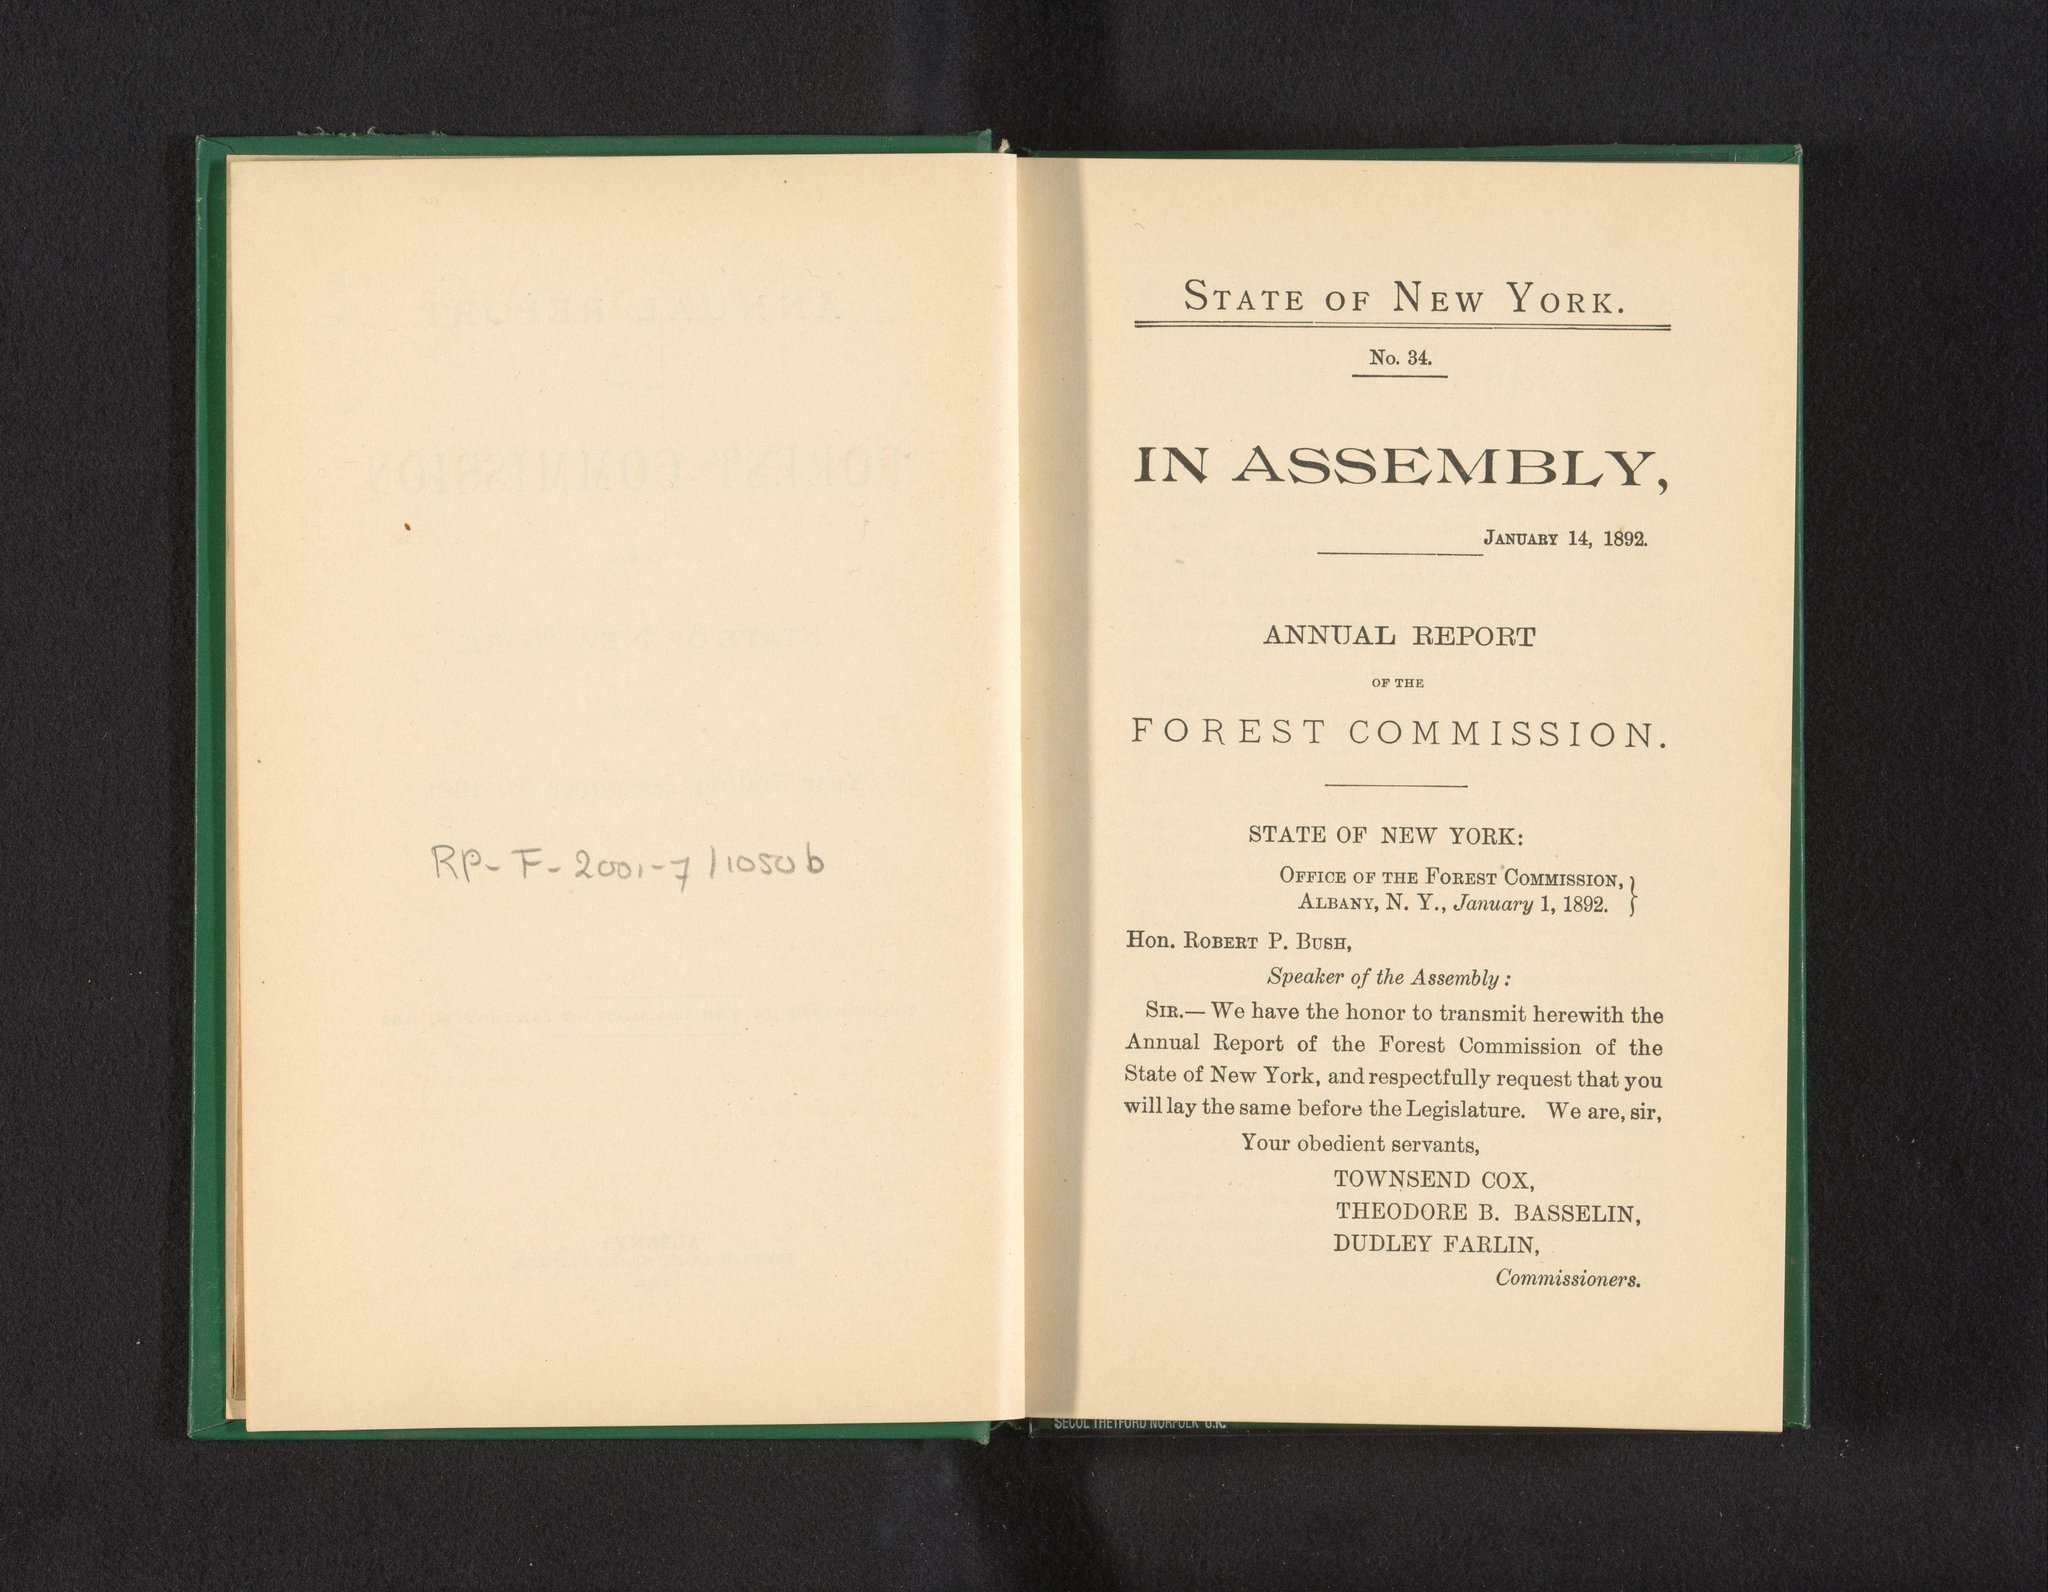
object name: book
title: Annual report of the Forest Commission of the State of New York for the year ending December 31, 1891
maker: james b. lyon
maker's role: printer, publisher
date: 1892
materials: cardboard, linen, paper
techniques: photograph, lithograph, printing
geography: albany